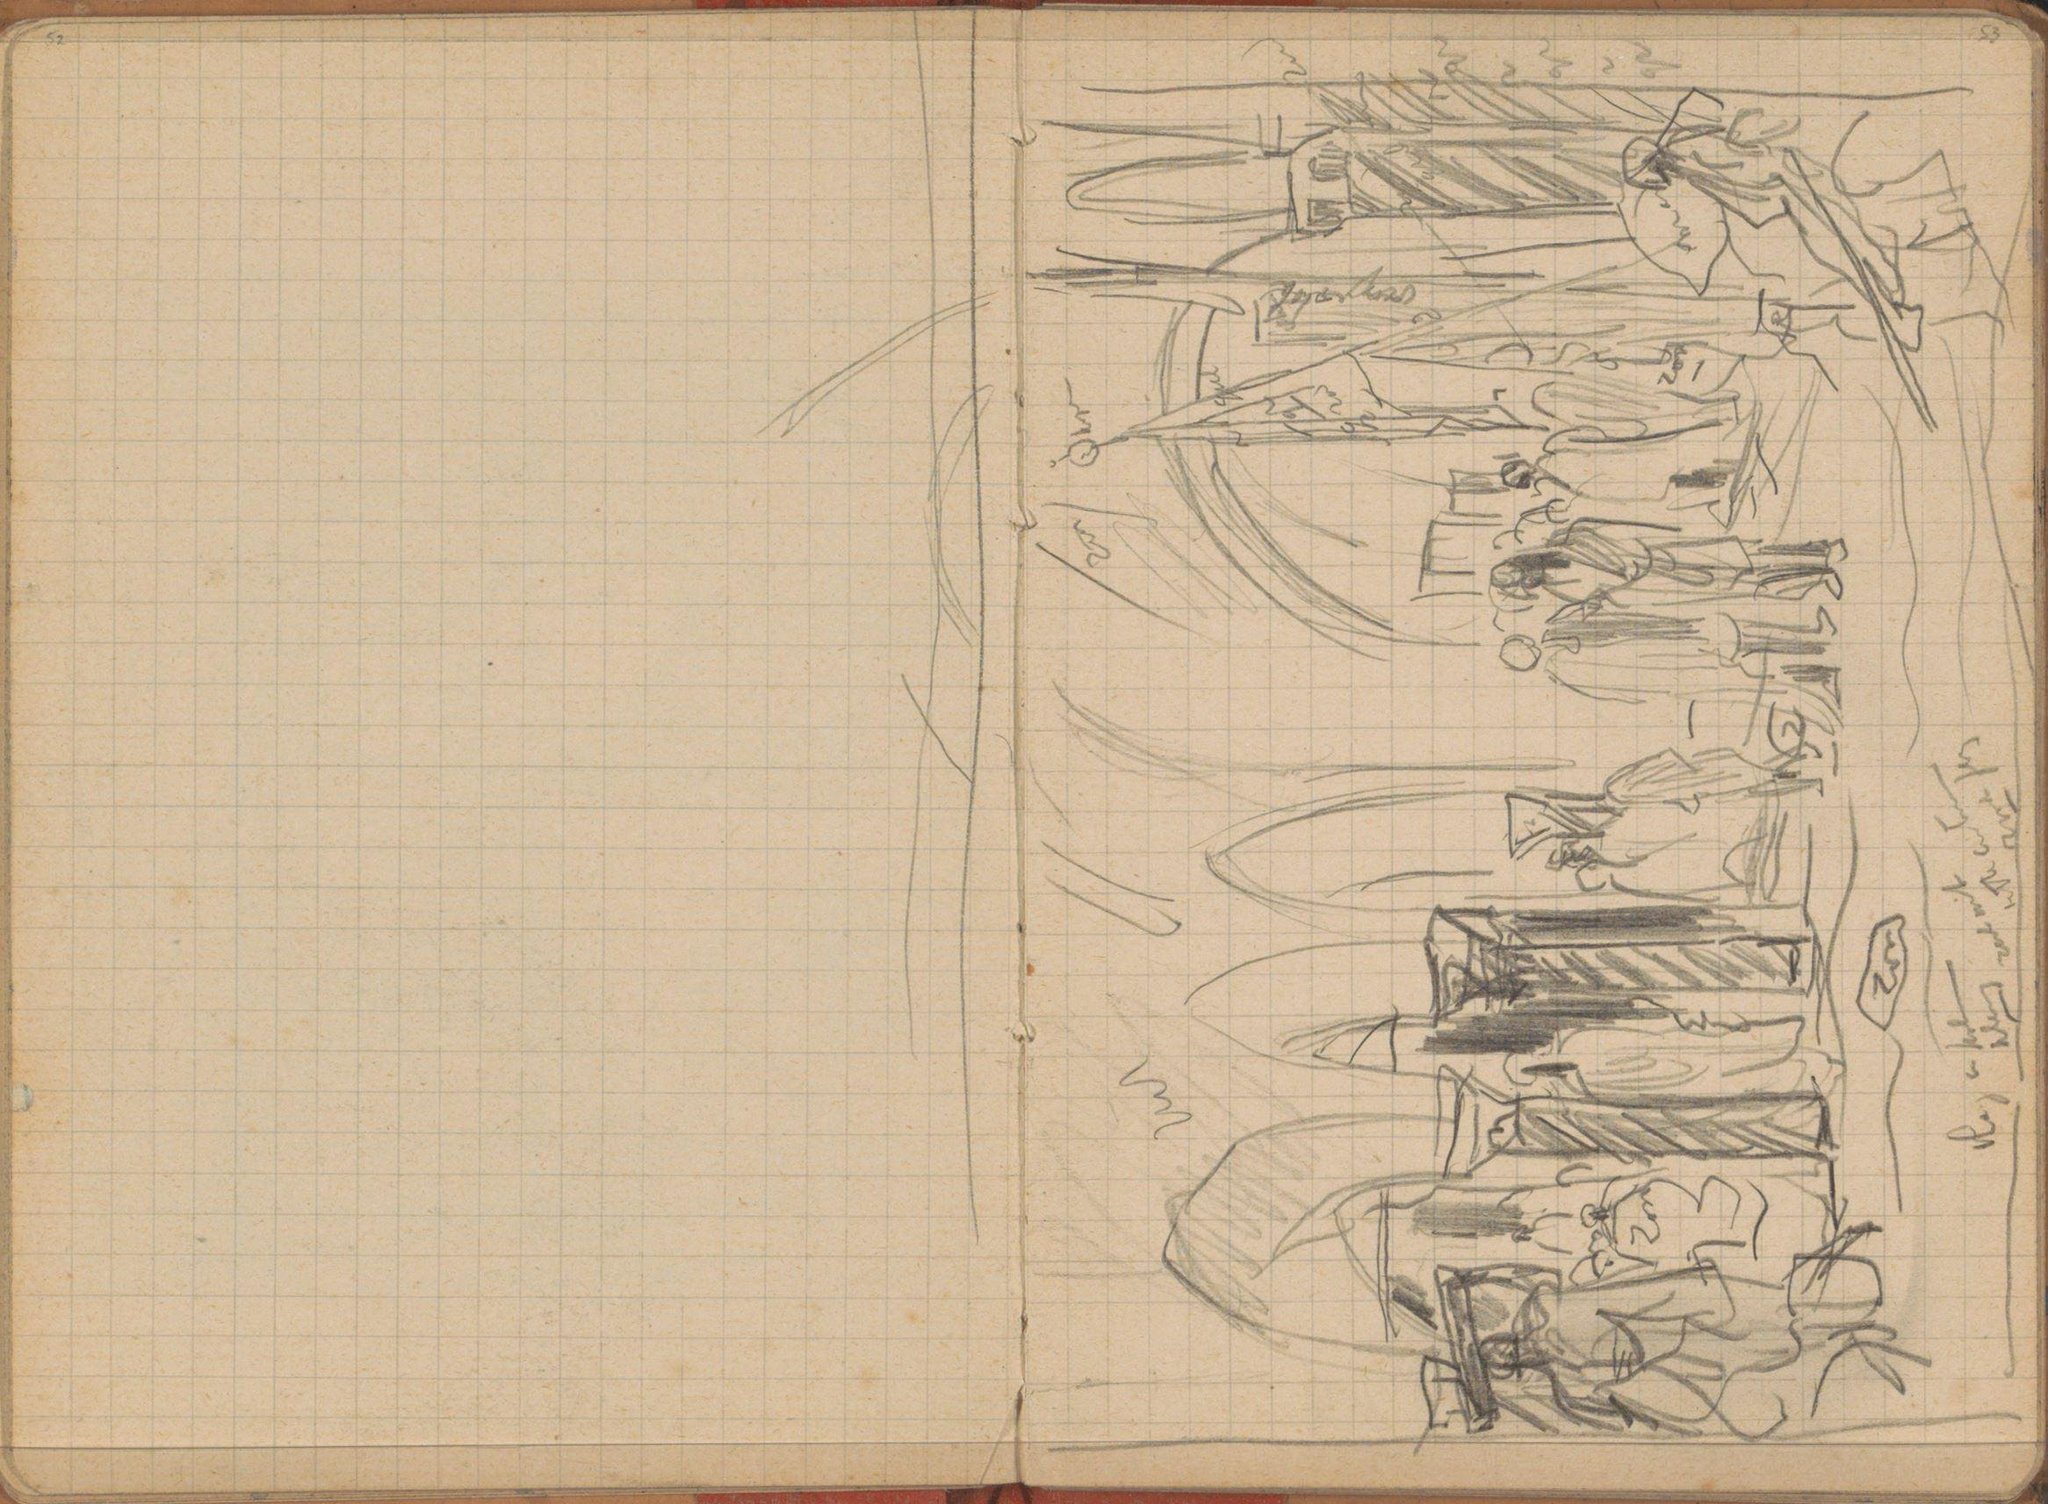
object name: sketchbook leaf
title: Figuren in een straat bij een gebouw met arcaden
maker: marius bauer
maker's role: draughtsman, print maker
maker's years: 1867-1932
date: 1909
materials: pencil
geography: tunis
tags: arcade ~ architecture, street (+ city(-scape) with figures, staffage)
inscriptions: kleurnotitie, handgeschreven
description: Pagina 52 en 53 uit een schetsboek met 67 bladen.